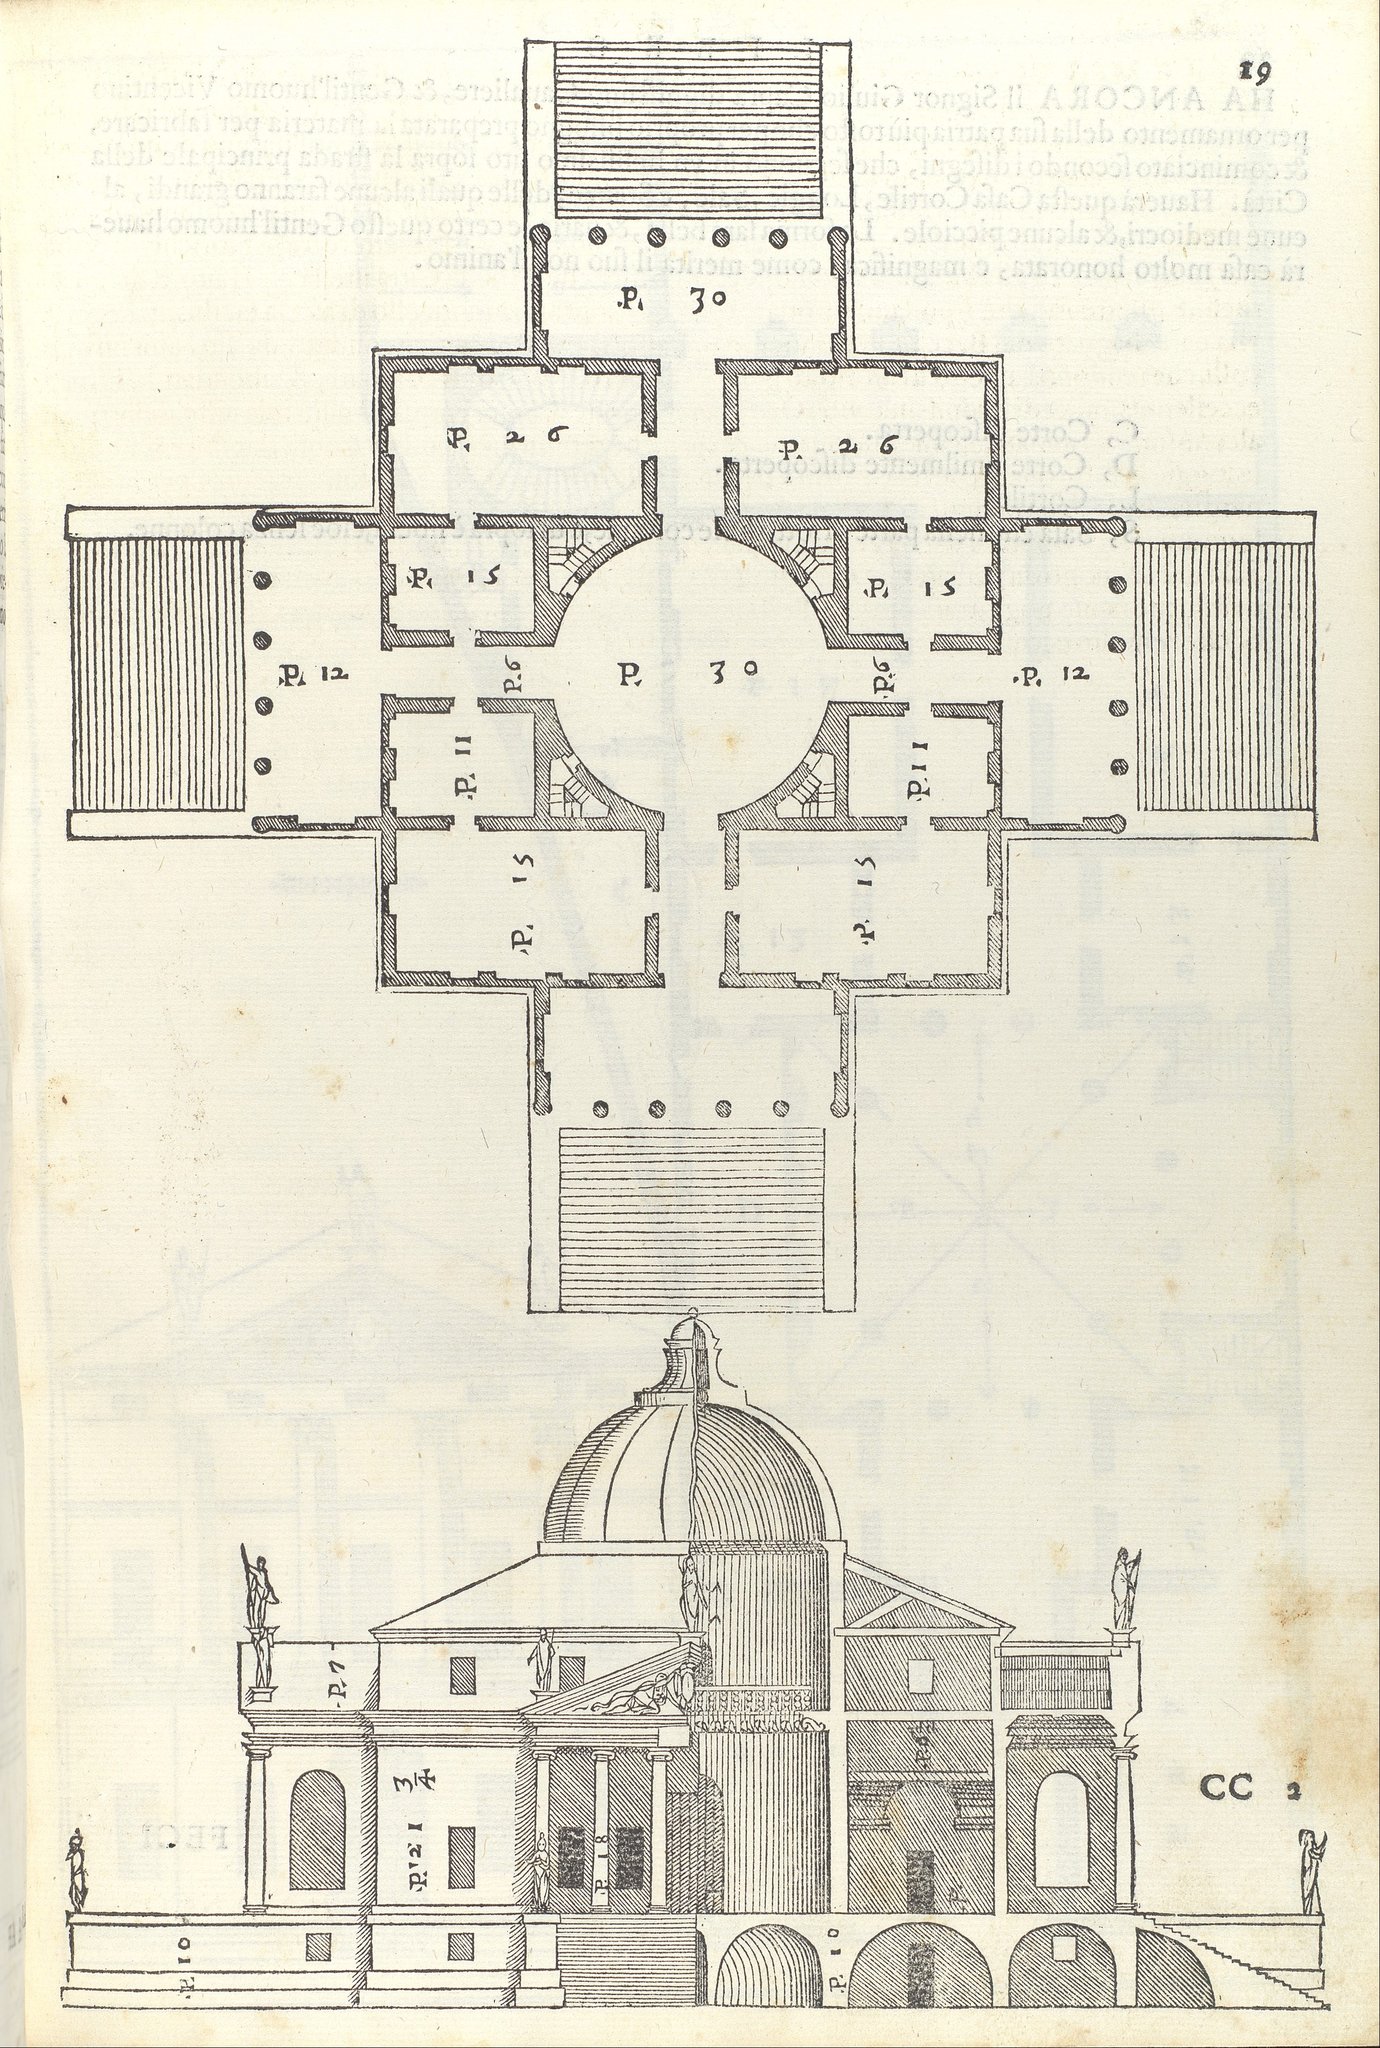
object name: book print ornament architecture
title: Villa Almerico (Villa Rotunda), from I quattro libri dell'architettura di Andrea Palladio (Book 2, page 19)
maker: andrea palladio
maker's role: author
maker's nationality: italian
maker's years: 1508-1580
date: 1570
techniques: printing, woodcut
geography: italy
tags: architecture